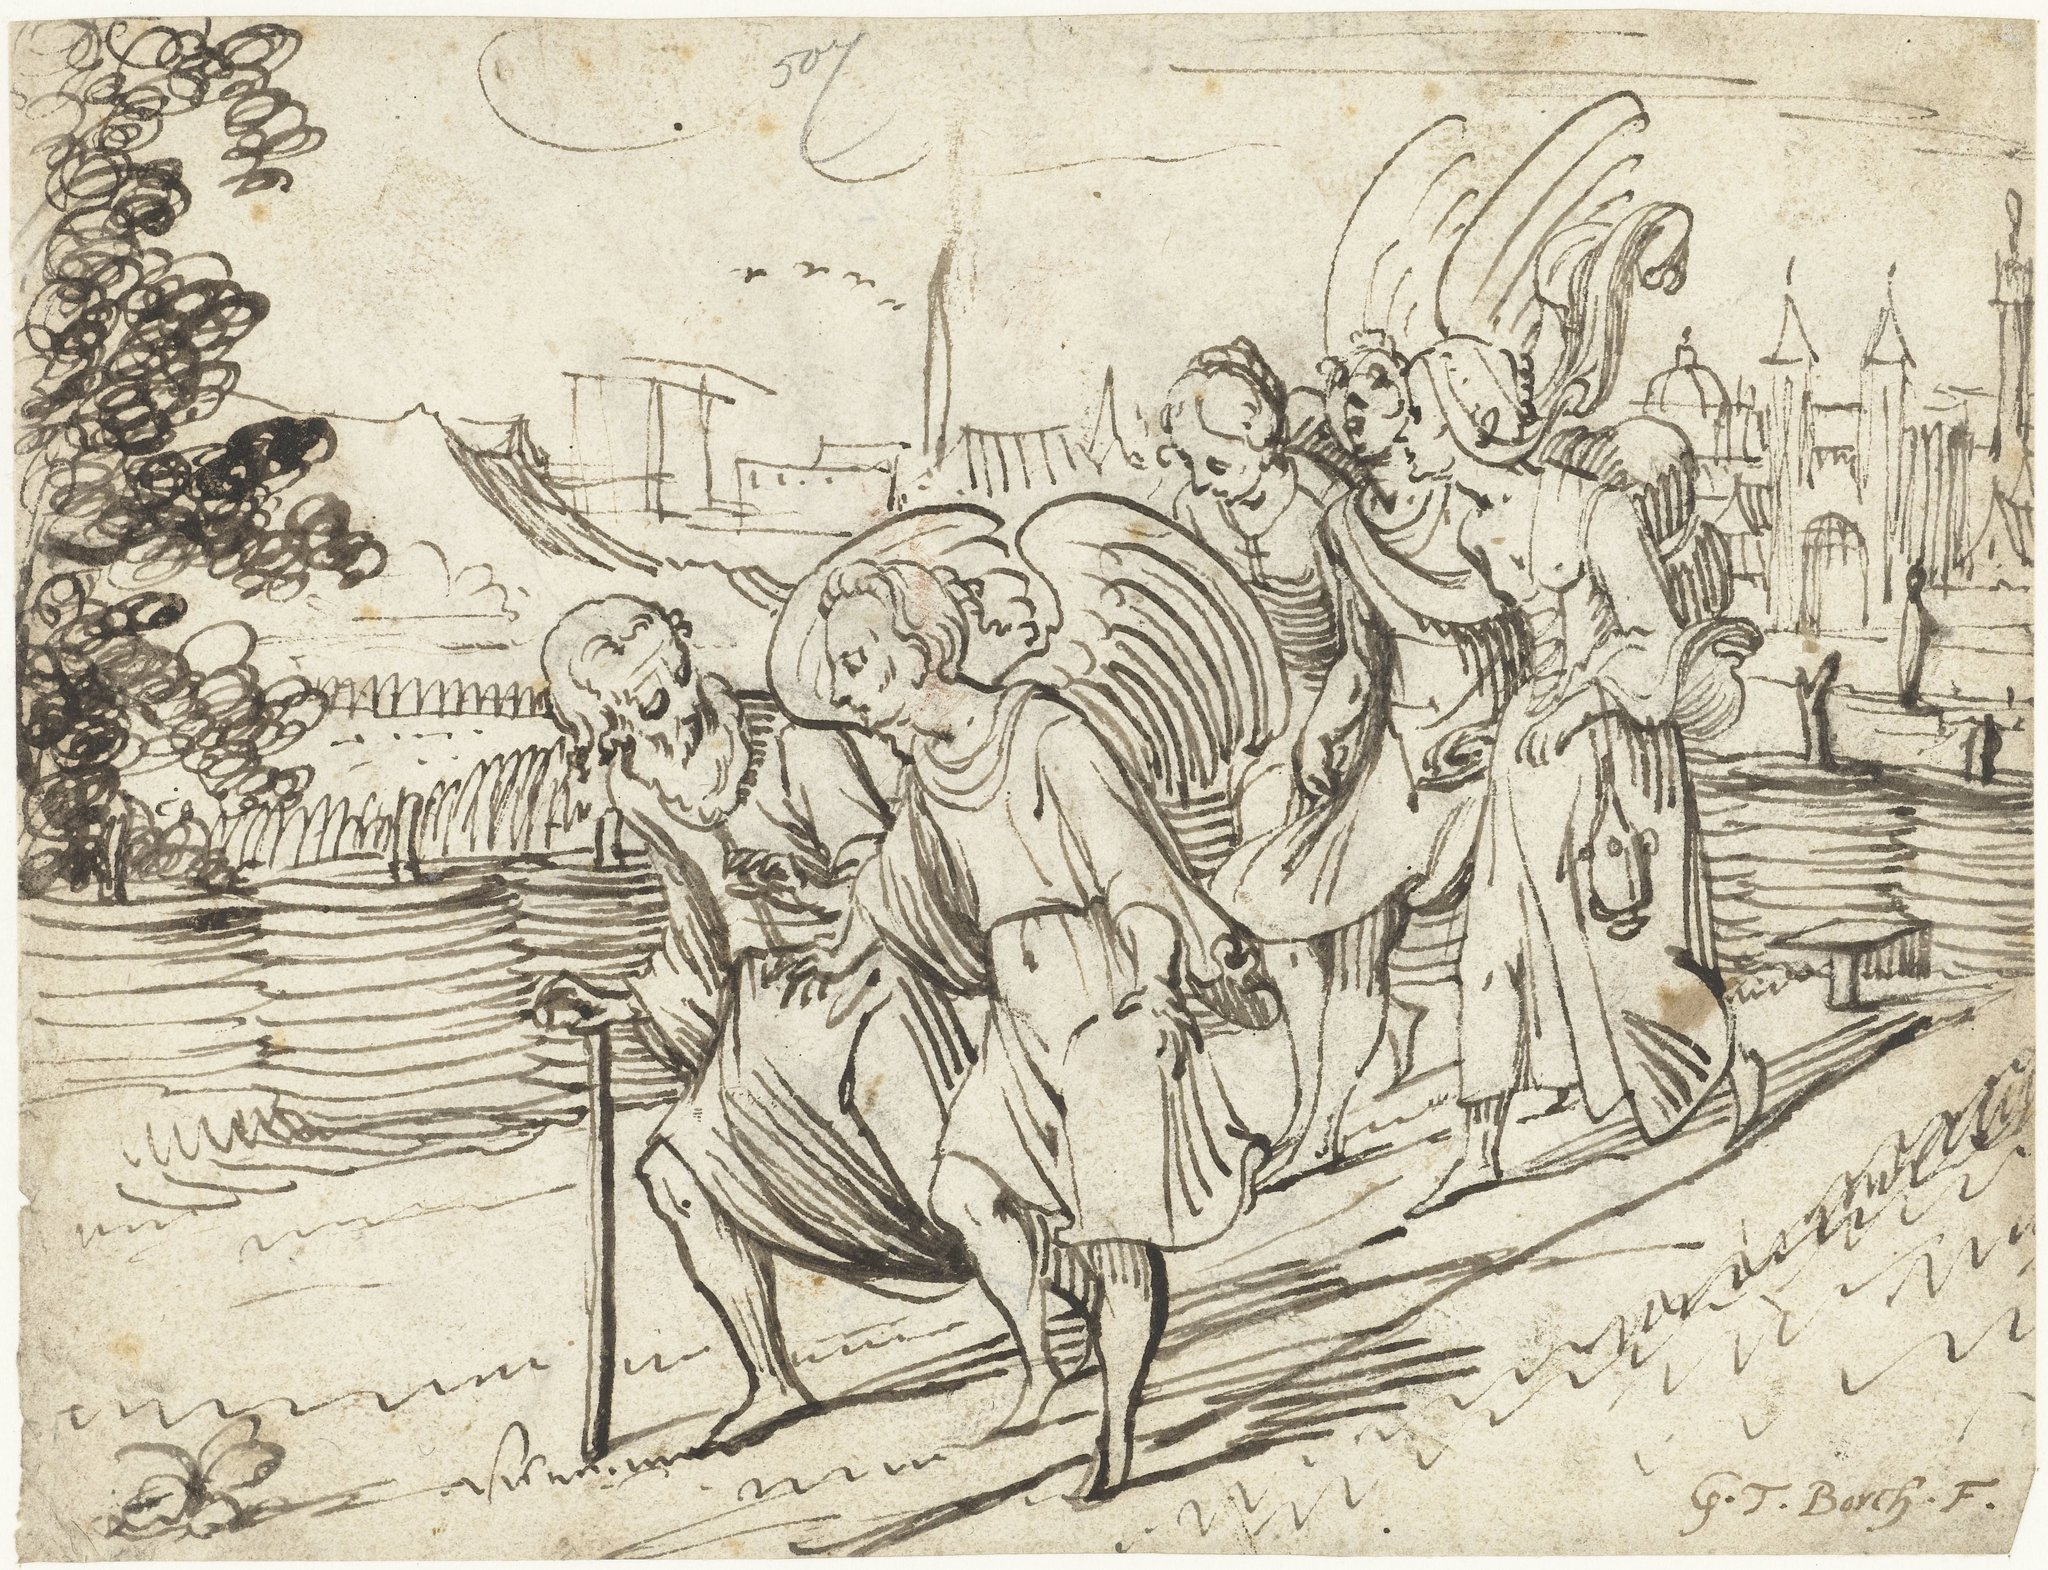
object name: drawing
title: Uittocht van Lot en zijn dochters met de engelen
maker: gerard ter borch (i)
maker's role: draughtsman, print maker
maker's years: 1584-1662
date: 1614-1616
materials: chalk, ink, paper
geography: zwolle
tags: the destruction of sodom and gomorrah: lot and his family flee to zoar, carrying their belongings; an angel may be showing the way (genesis 19:24-29)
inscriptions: signature: ‘G.T.Borch.F.’